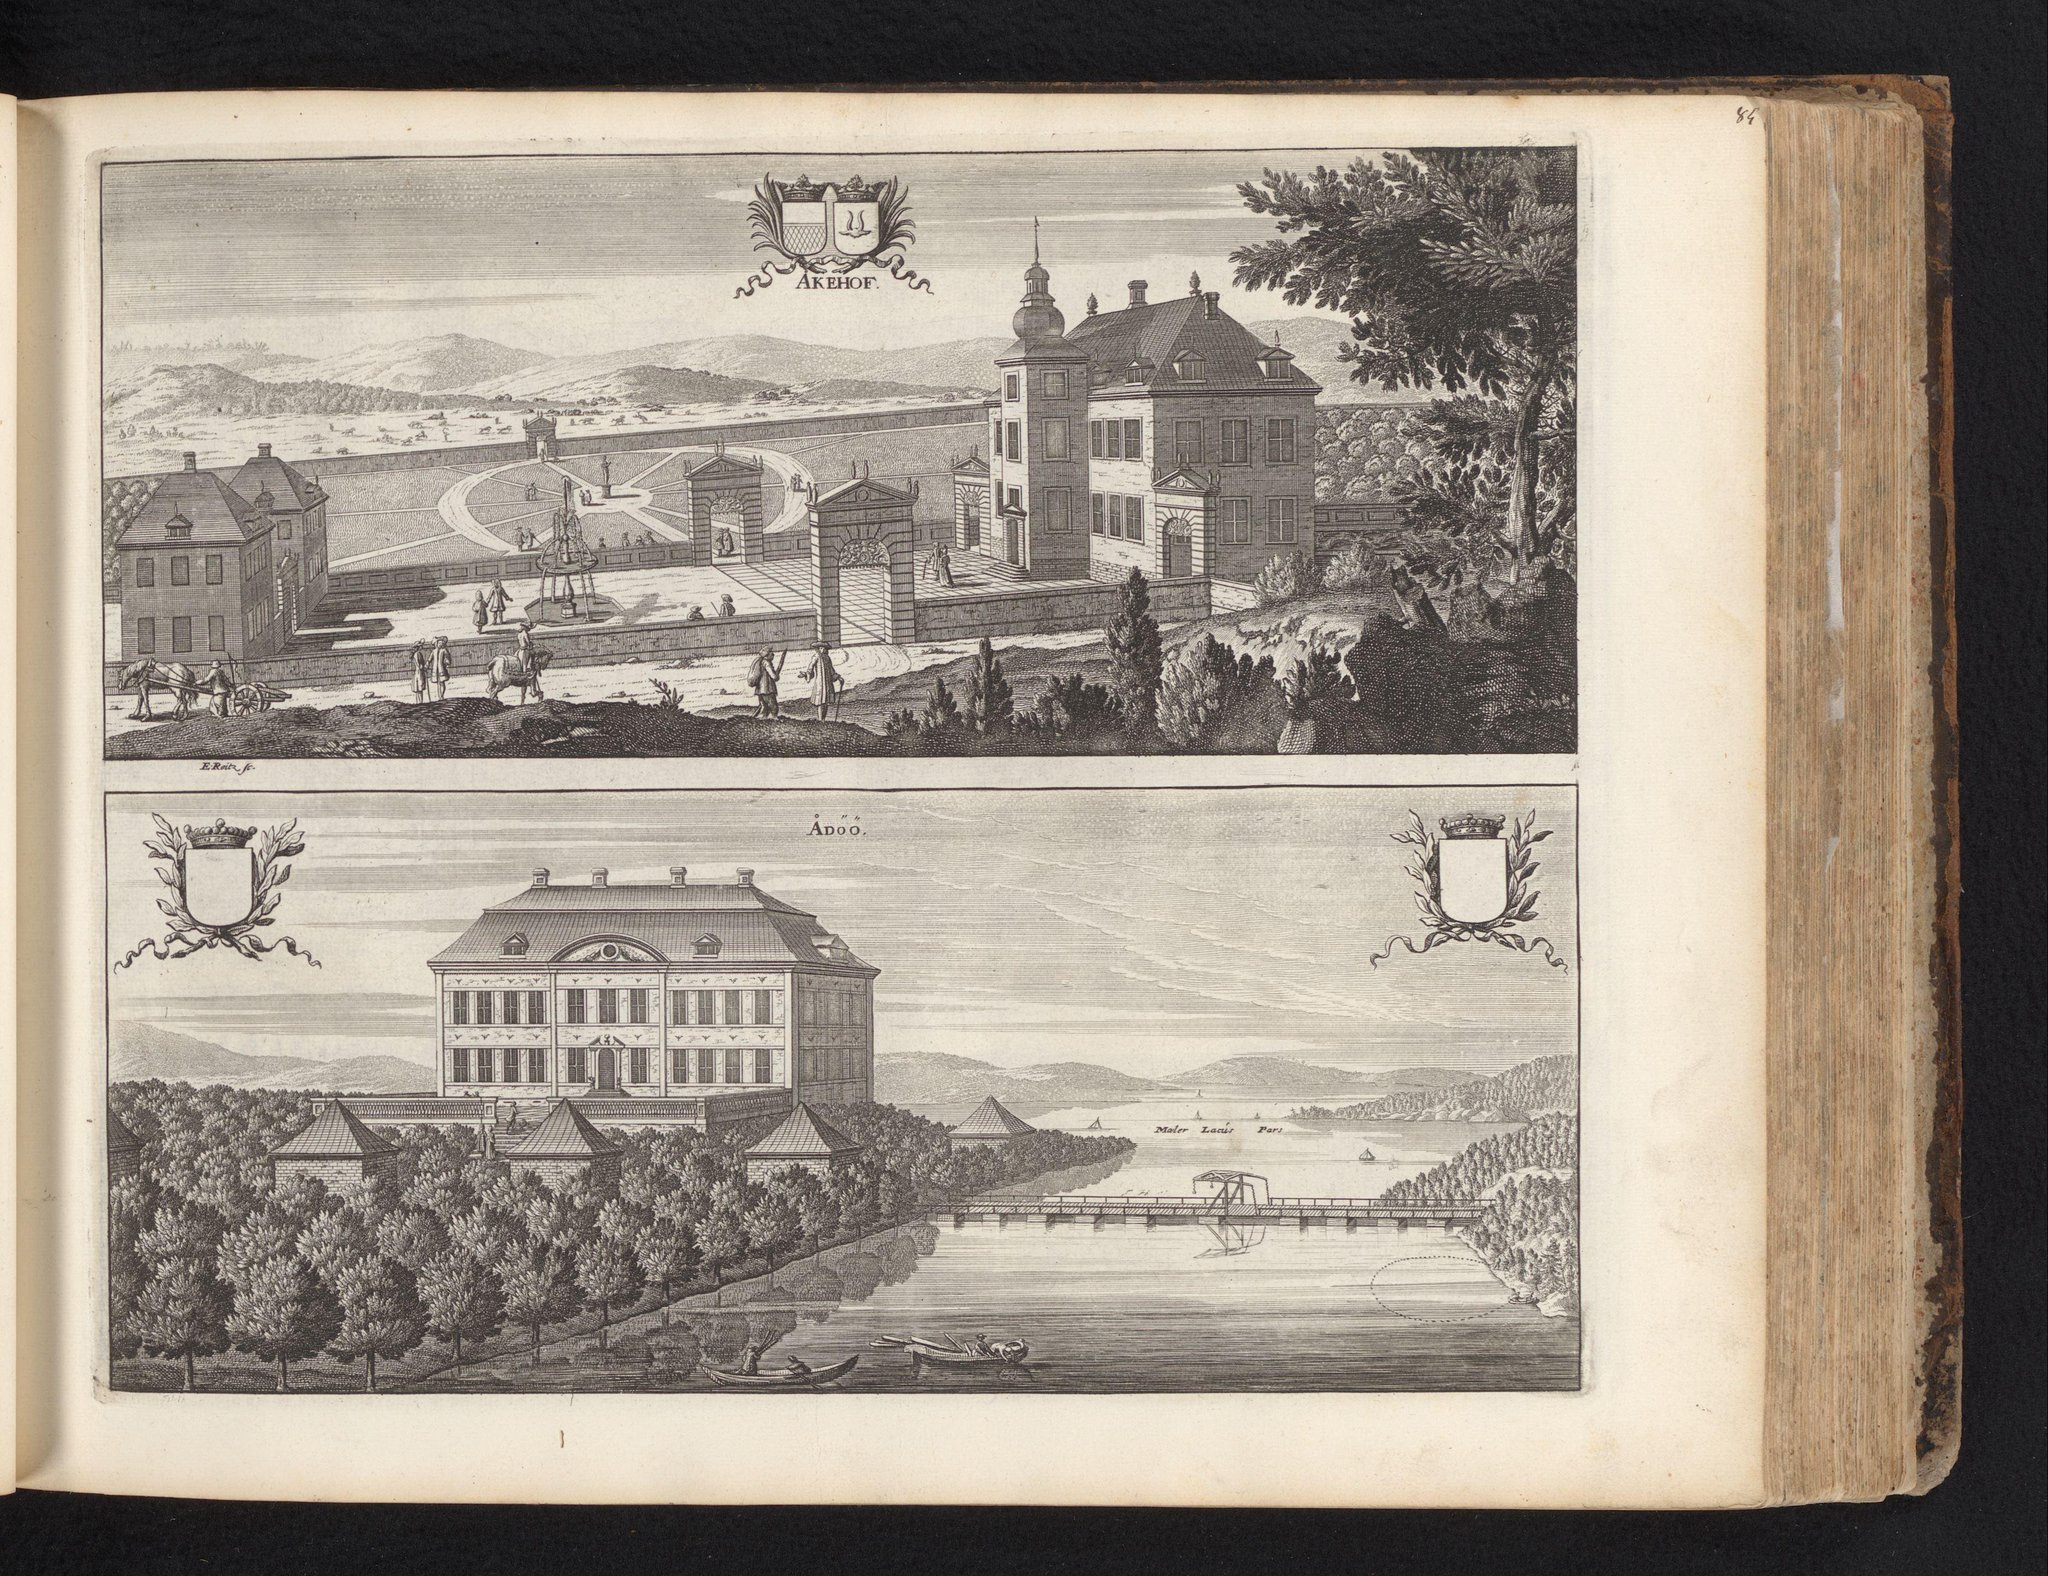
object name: album leaf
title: Gezicht op slot Åkeshov en herenhuis Adö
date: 1695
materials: paper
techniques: etching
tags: palace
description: Kungliga Biblioteket, 'Suecia': http://www.kb.se/samlingarna/Kartor-bilder/Suecia-antiqua/ (geraadpleegd november 2016).